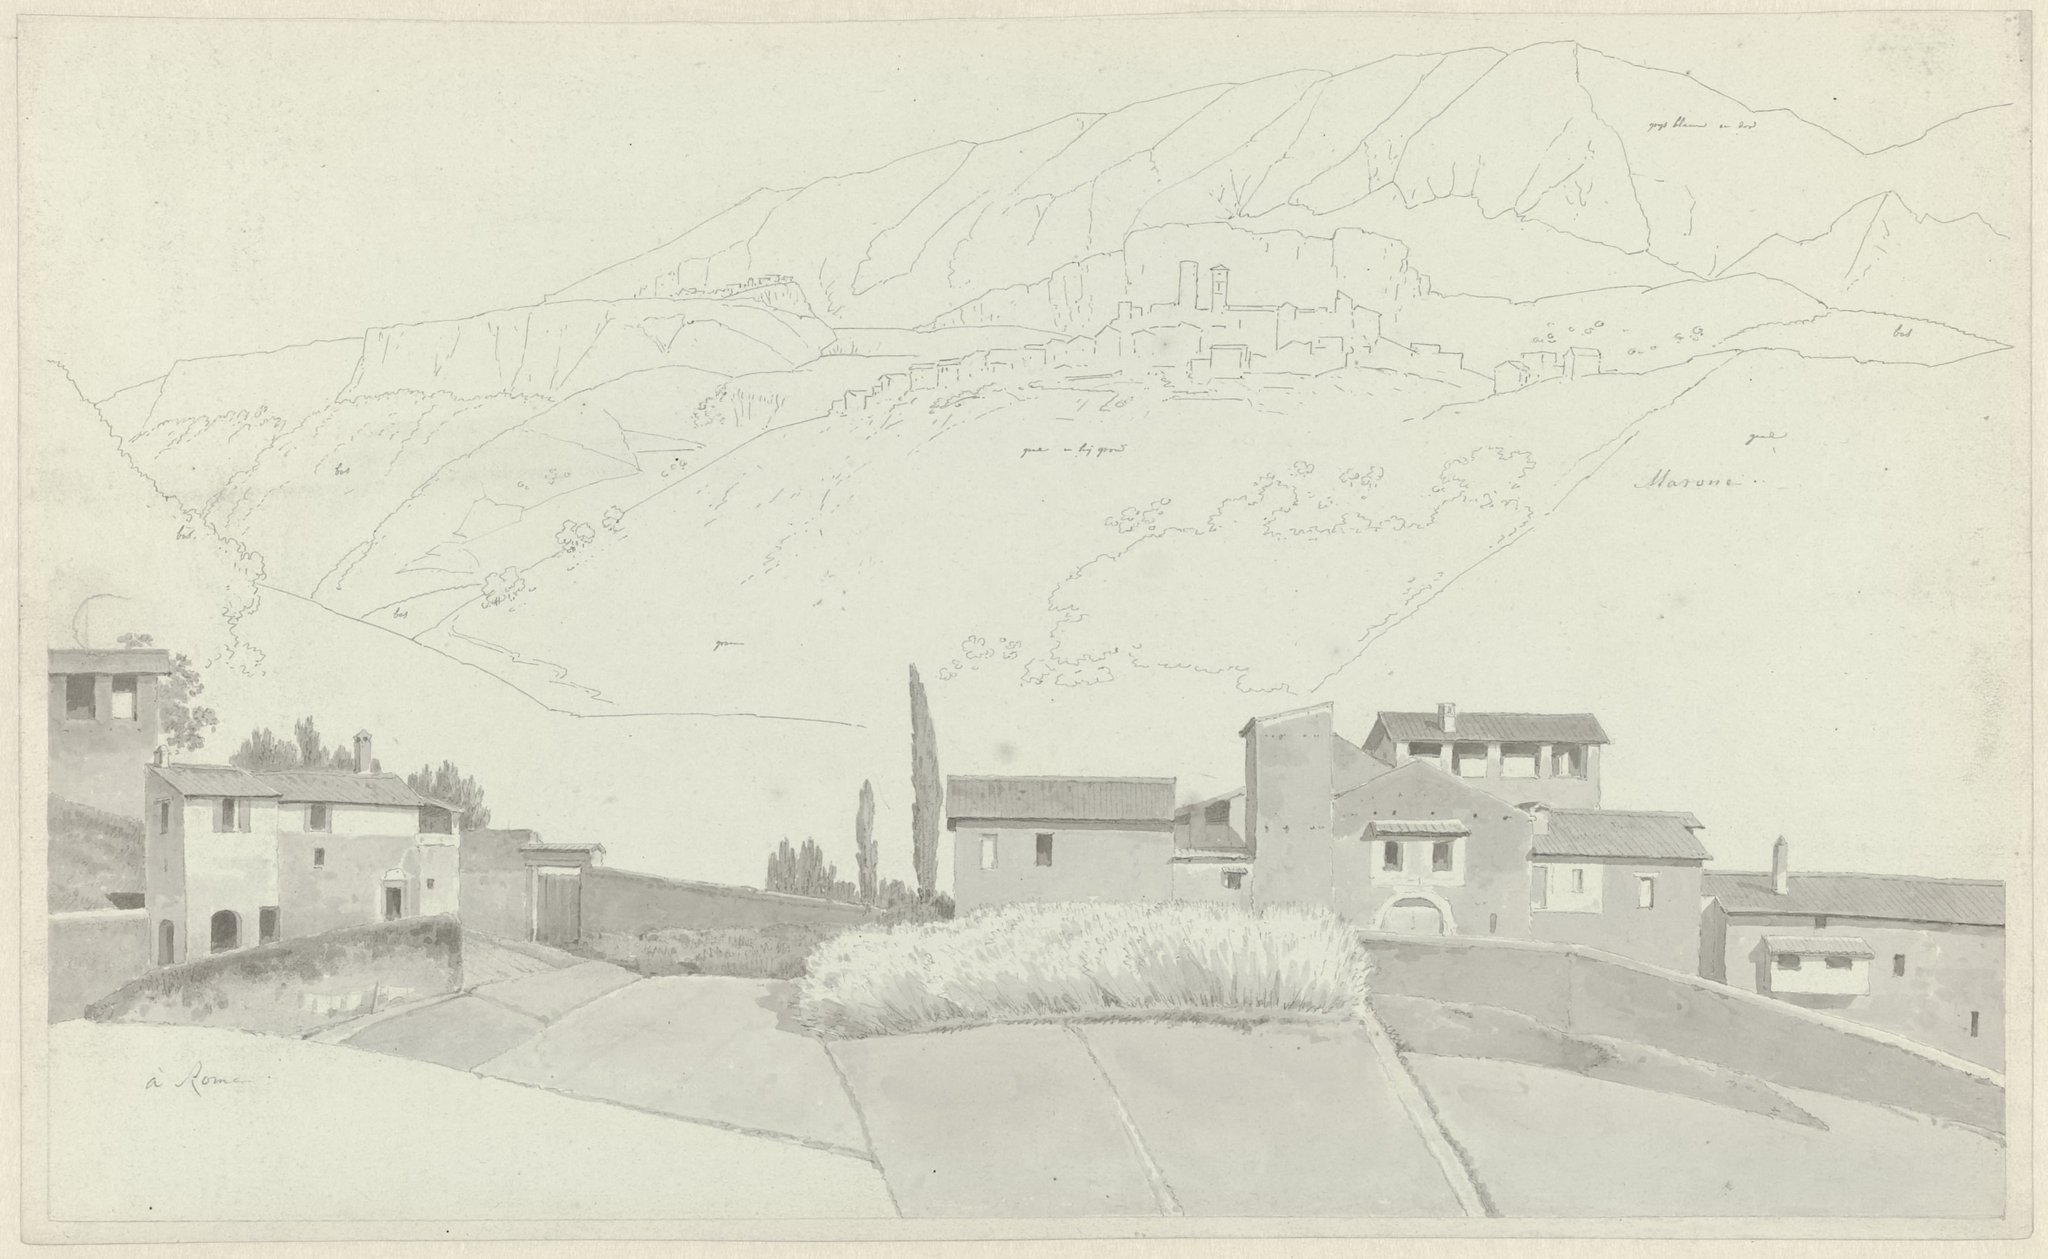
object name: drawing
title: View of Marone, and Houses in or near Rome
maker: josephus augustus knip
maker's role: draughtsman, painter, print maker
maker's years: 1777-1847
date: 1809-1810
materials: graphite, paper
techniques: brush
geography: italy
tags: city-view in general; 'veduta', (high) hill, rome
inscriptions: inscription: ‘à Roma’, inscription: ‘Marone’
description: Marone is a town in northern Italy, east of Bergamo. In this drawing, too, the foreground and background have nothing to do with one another. Knip could have drawn the view of Marone on his way back to the Netherlands.